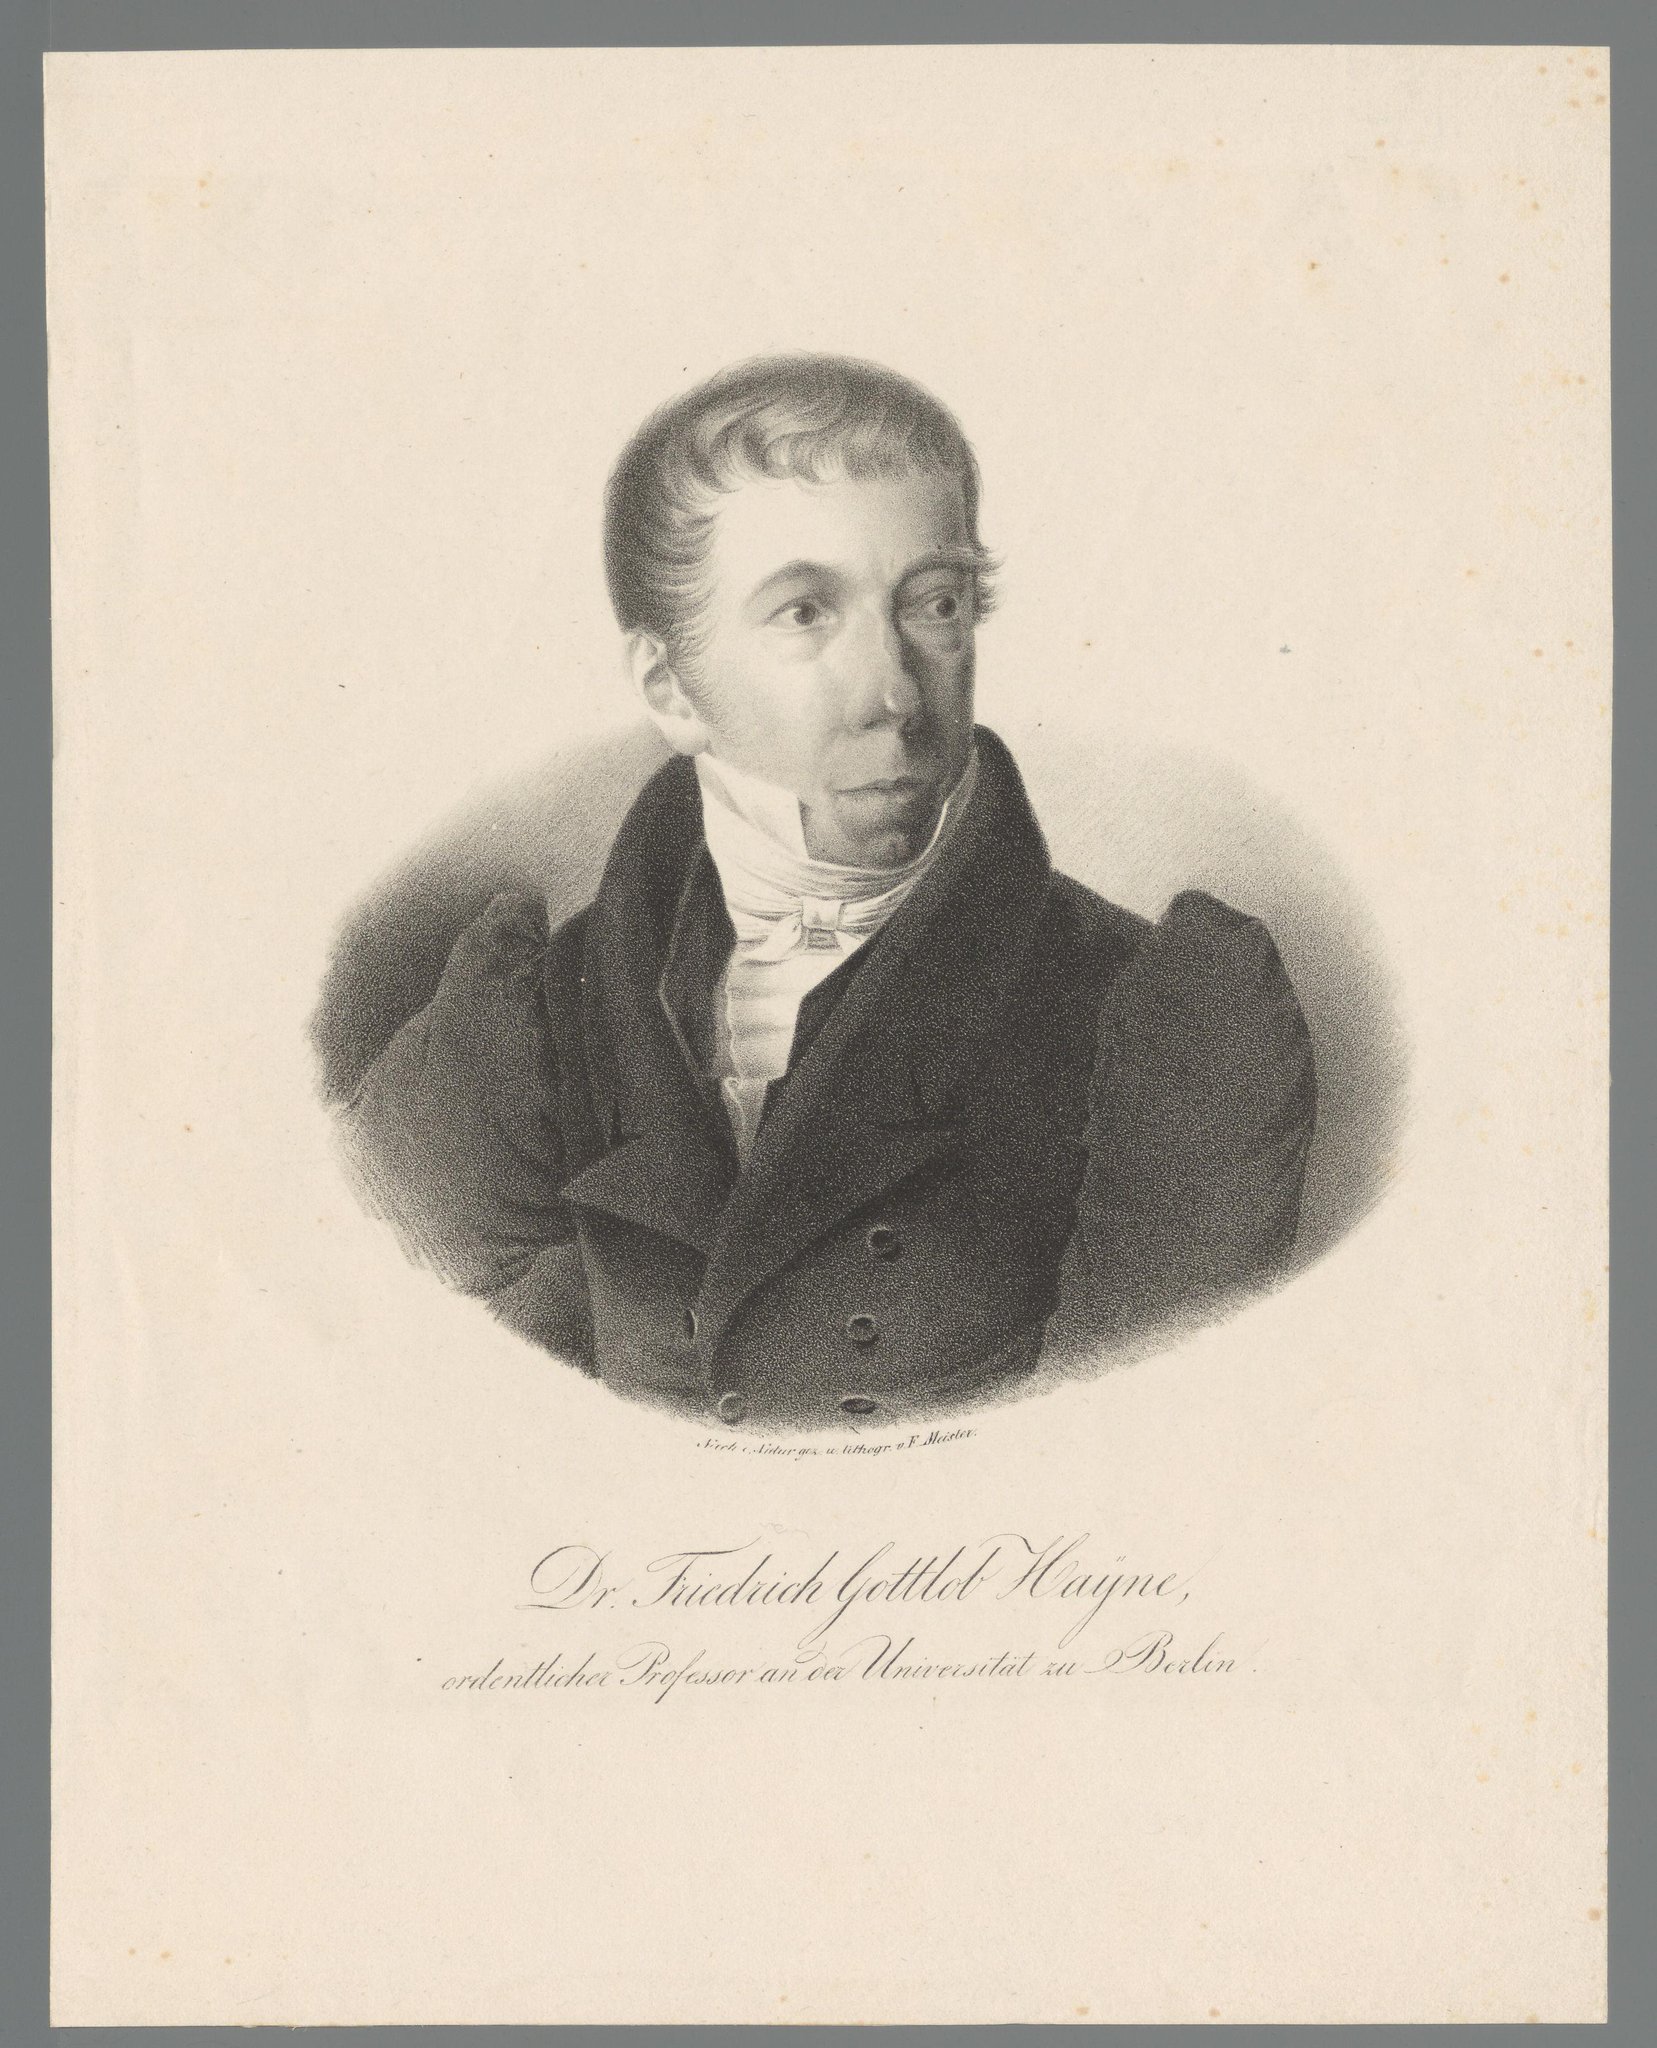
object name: print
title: Portret van Friedrich Gottlob Hayne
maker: ferdinand meister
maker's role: print maker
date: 1828-1840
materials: paper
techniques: lithograph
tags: berlin, historical persons, professor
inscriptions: collector's mark: Lugt 2228